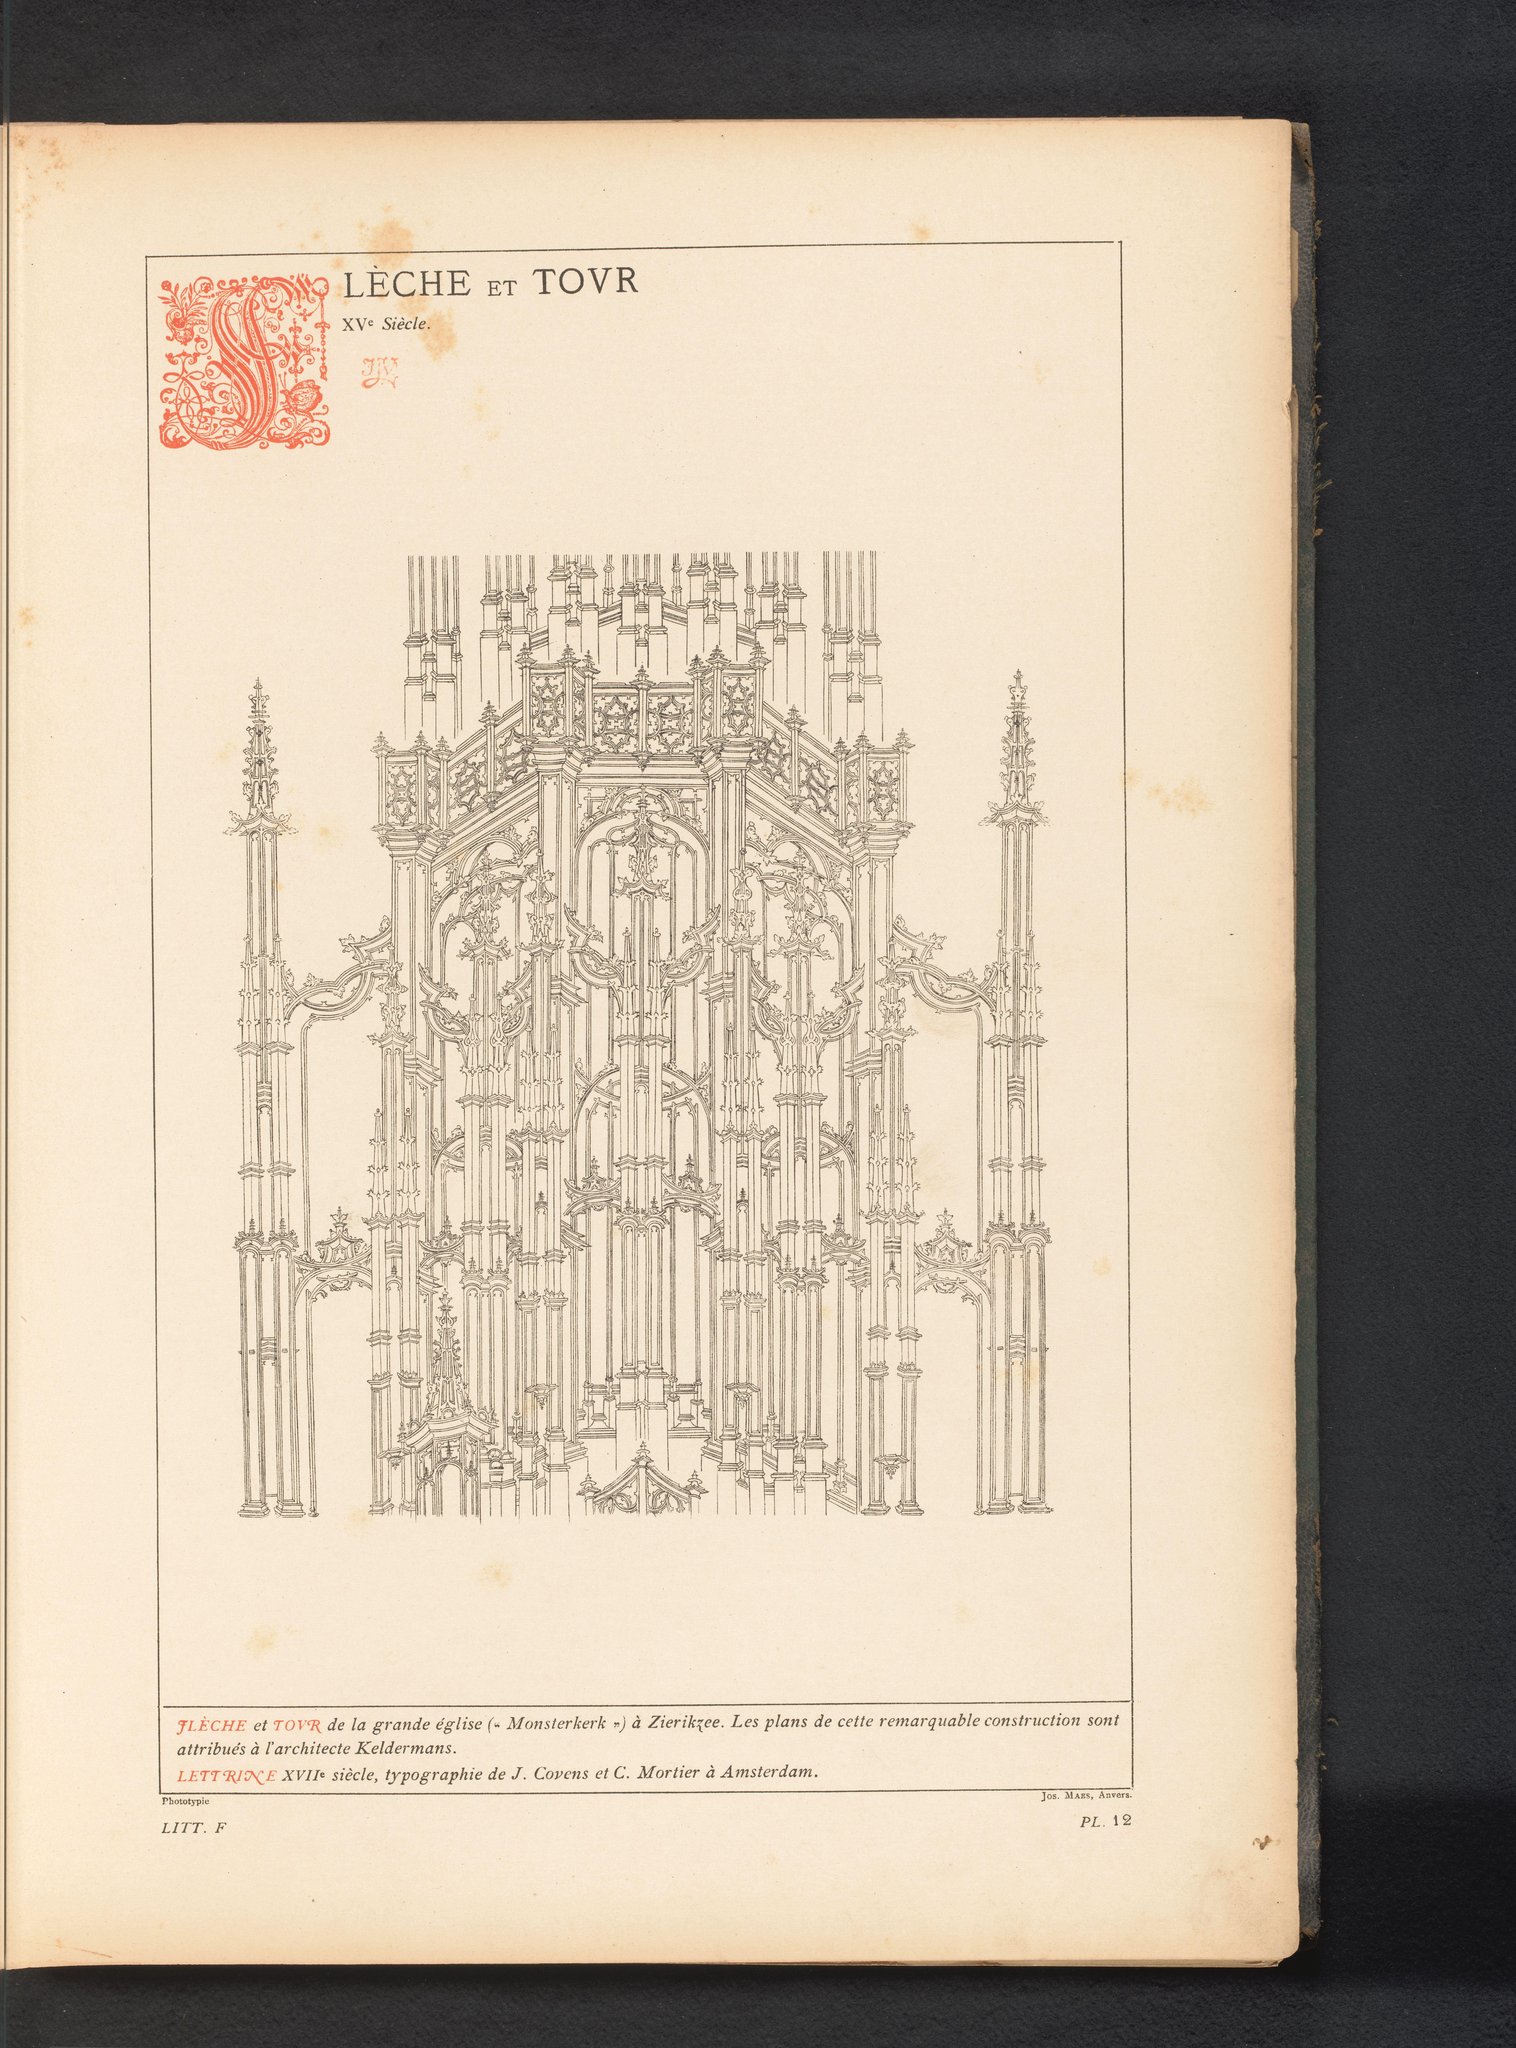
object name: page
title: Reproductie van een prent van een ontwerp van de Sint-Lievensmonstertoren in Zierikzee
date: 1875-1880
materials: paper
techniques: photolithography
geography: antwerp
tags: parts of church exterior and annexes: tower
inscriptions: inscription: ‘FLÈCHE et TOUR (...)’, inscription: ‘LITT. F. - PL. 12’, monogram: ‘JJvY’